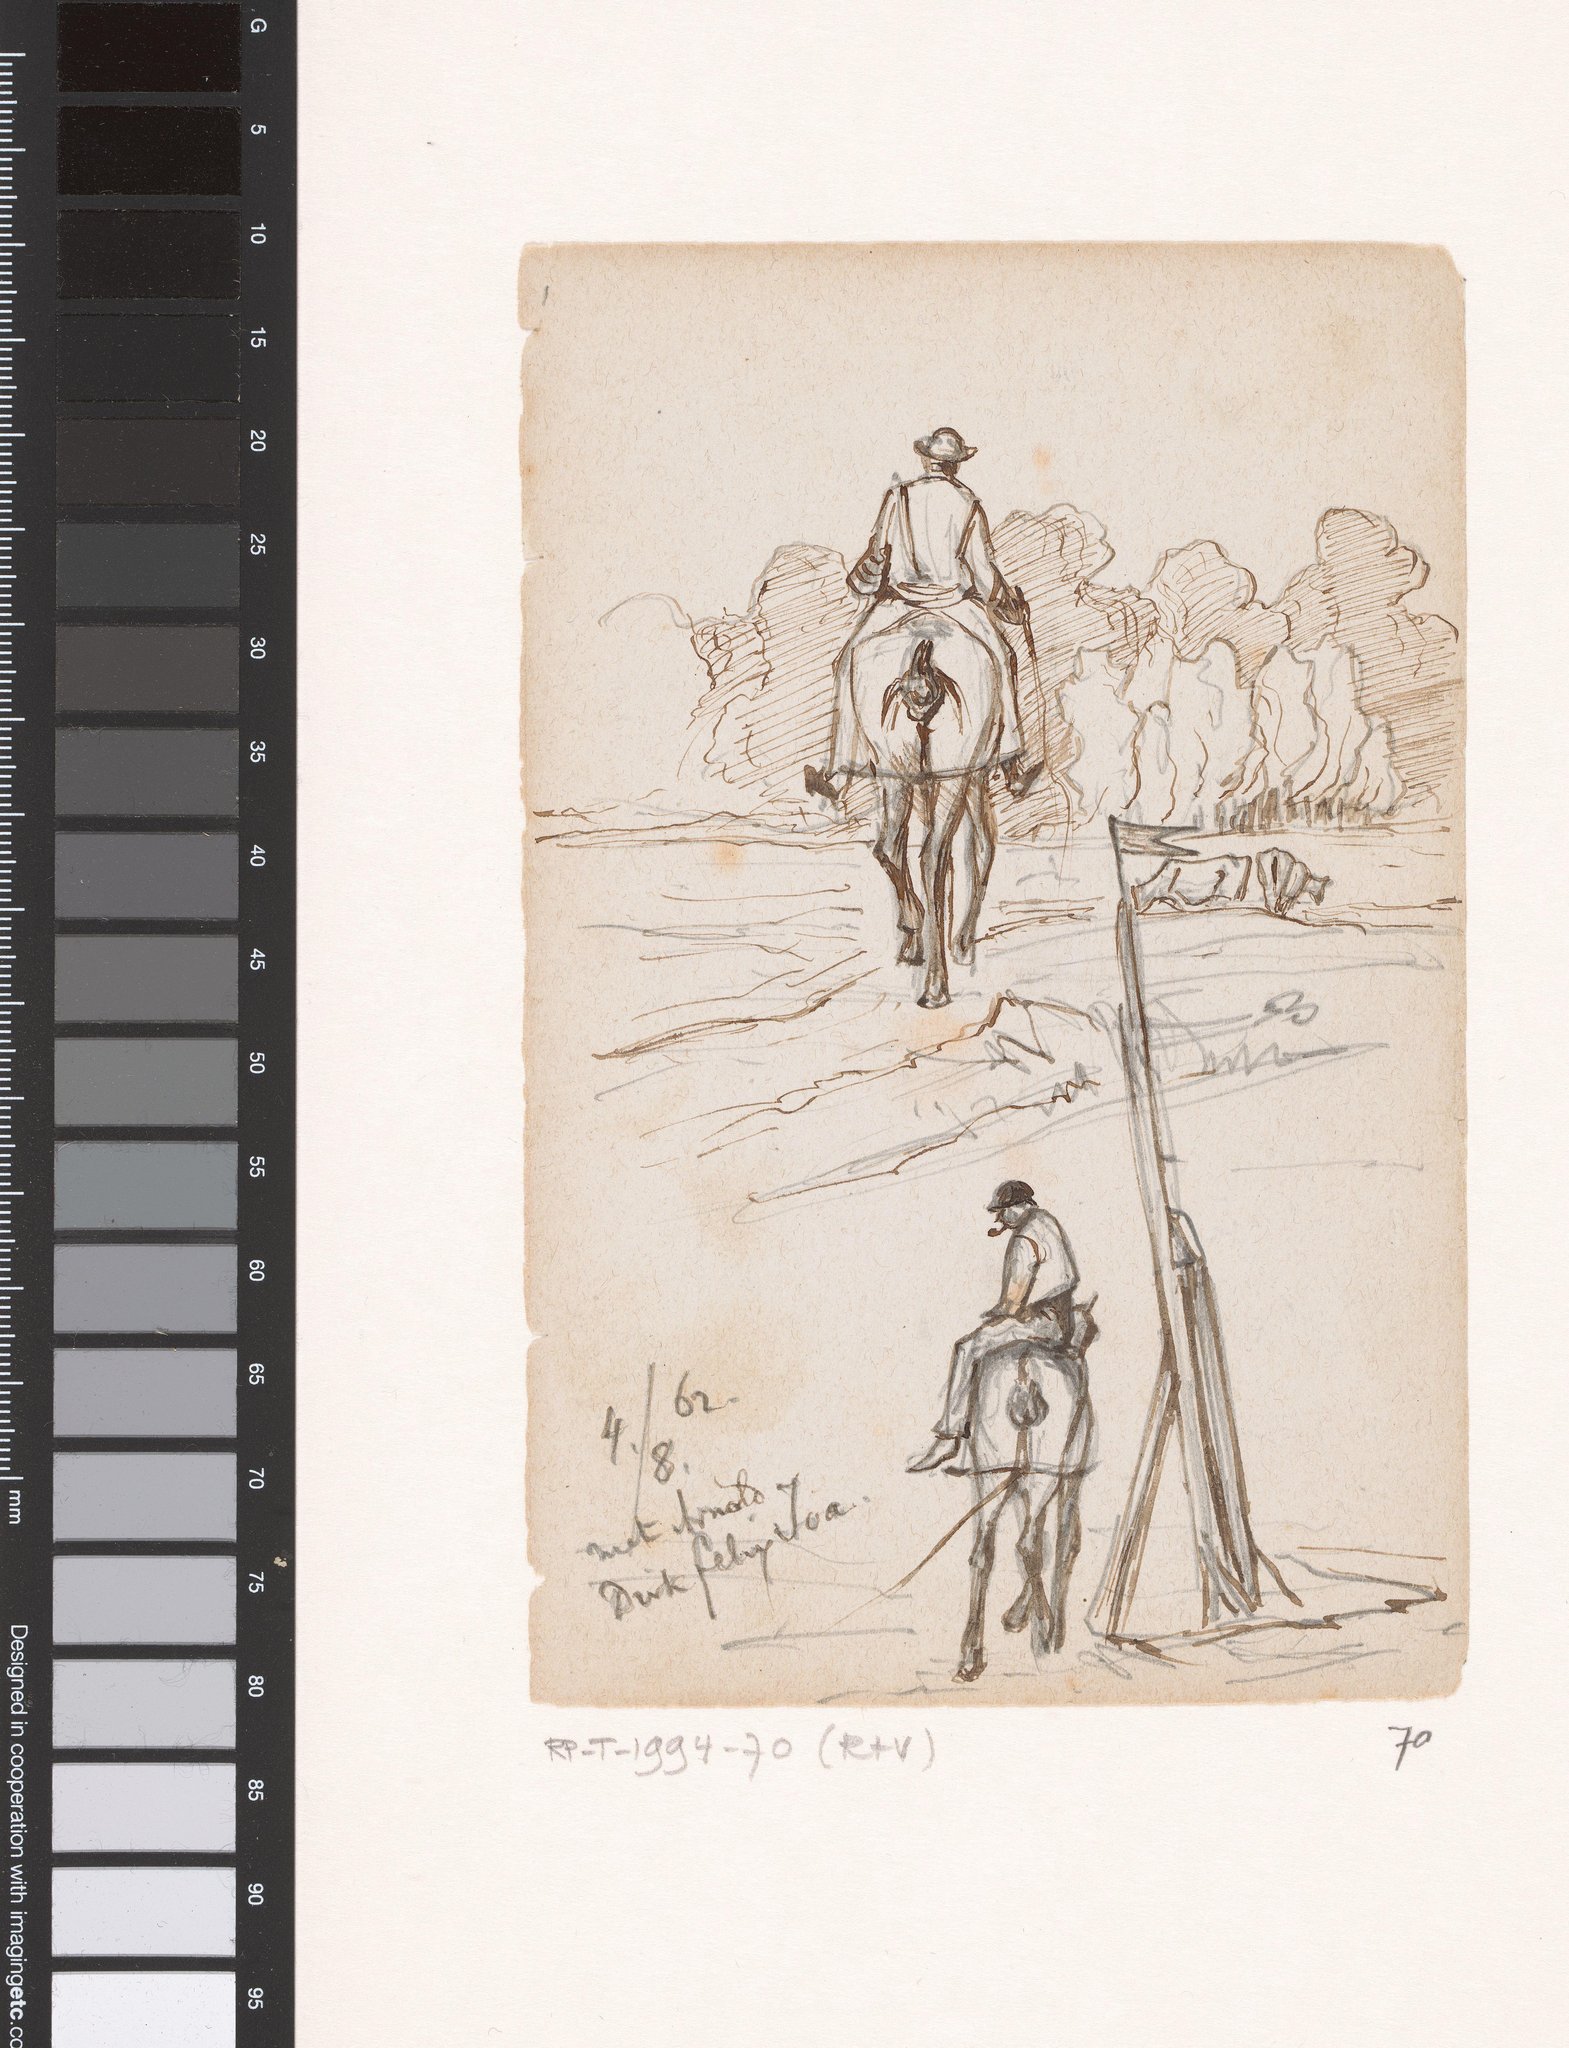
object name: drawing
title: Twee schetsjes van een jager op een jaagpad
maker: johannes tavenraat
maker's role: draughtsman, painter, print maker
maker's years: 1809-1881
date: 1862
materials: ink, paper, pencil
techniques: pen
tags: tow-boat, towing-barge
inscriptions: date and inscription: ‘4/8 62 / met Arnold op Dirk ...’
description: Twee schetsjes van een ruiter, een jager op een jaagpad.